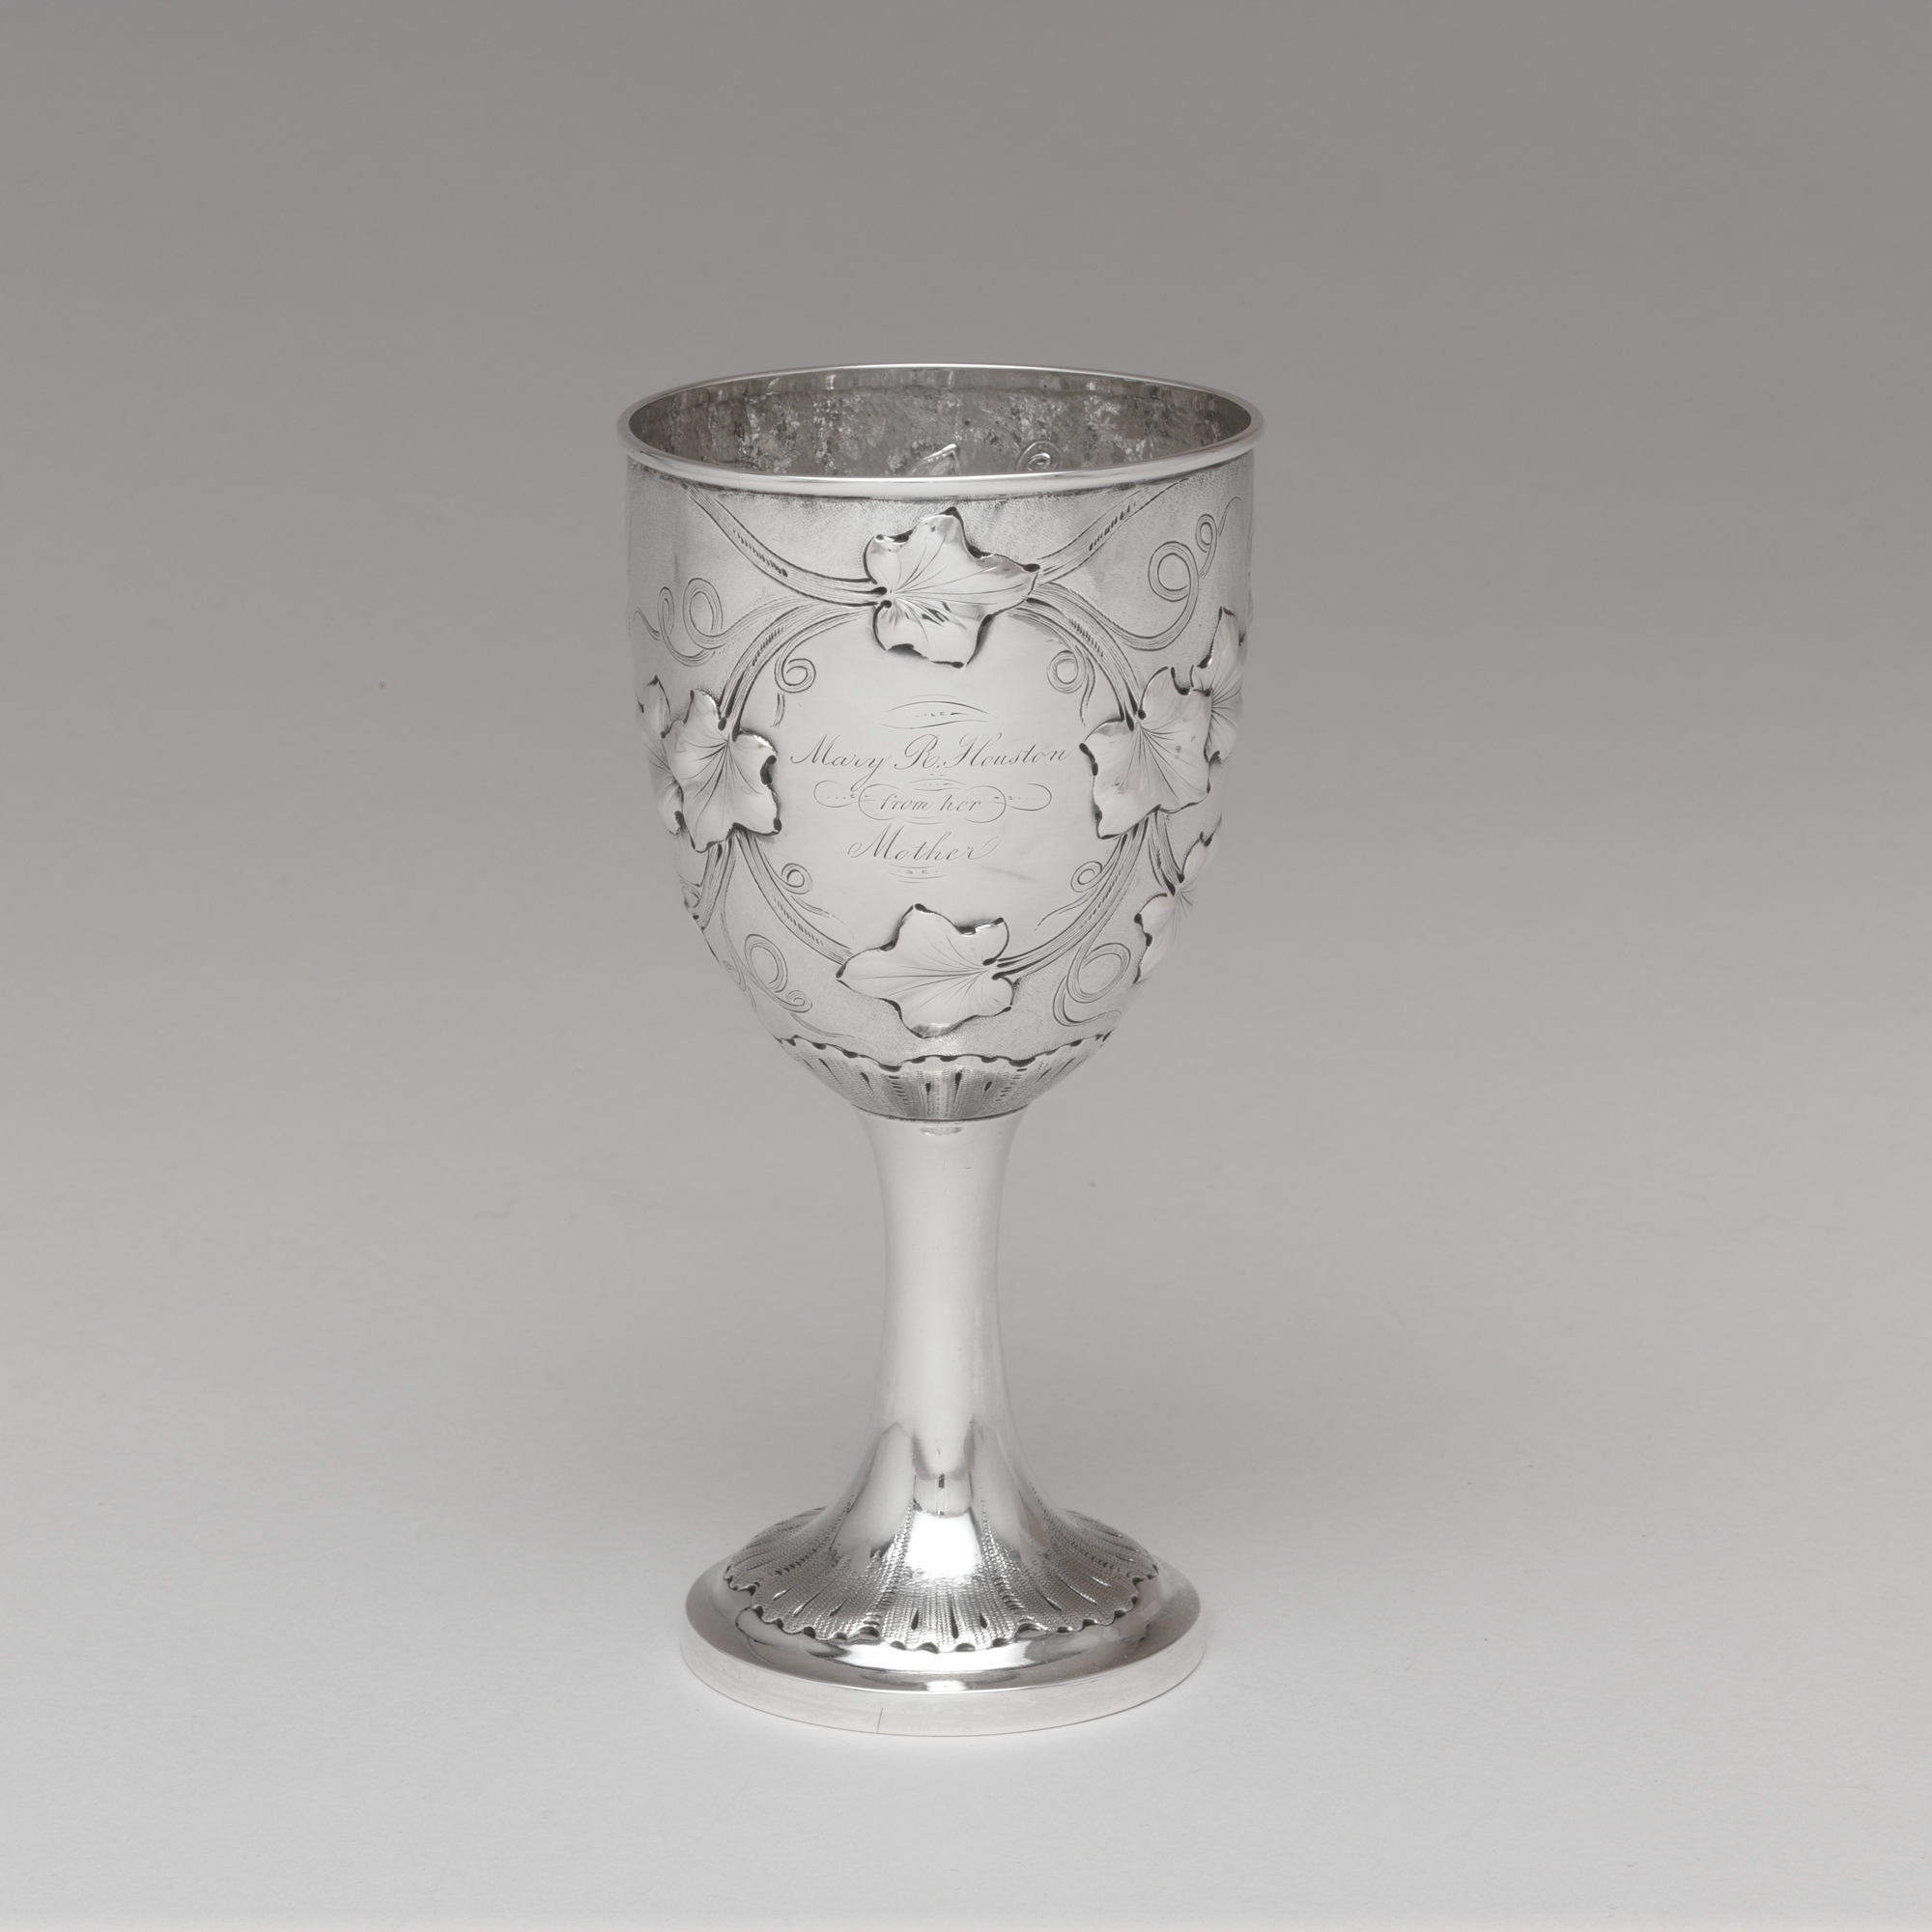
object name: goblet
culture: american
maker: robert and william wilson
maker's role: maker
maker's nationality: american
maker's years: 1825-1846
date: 1845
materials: silver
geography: united states